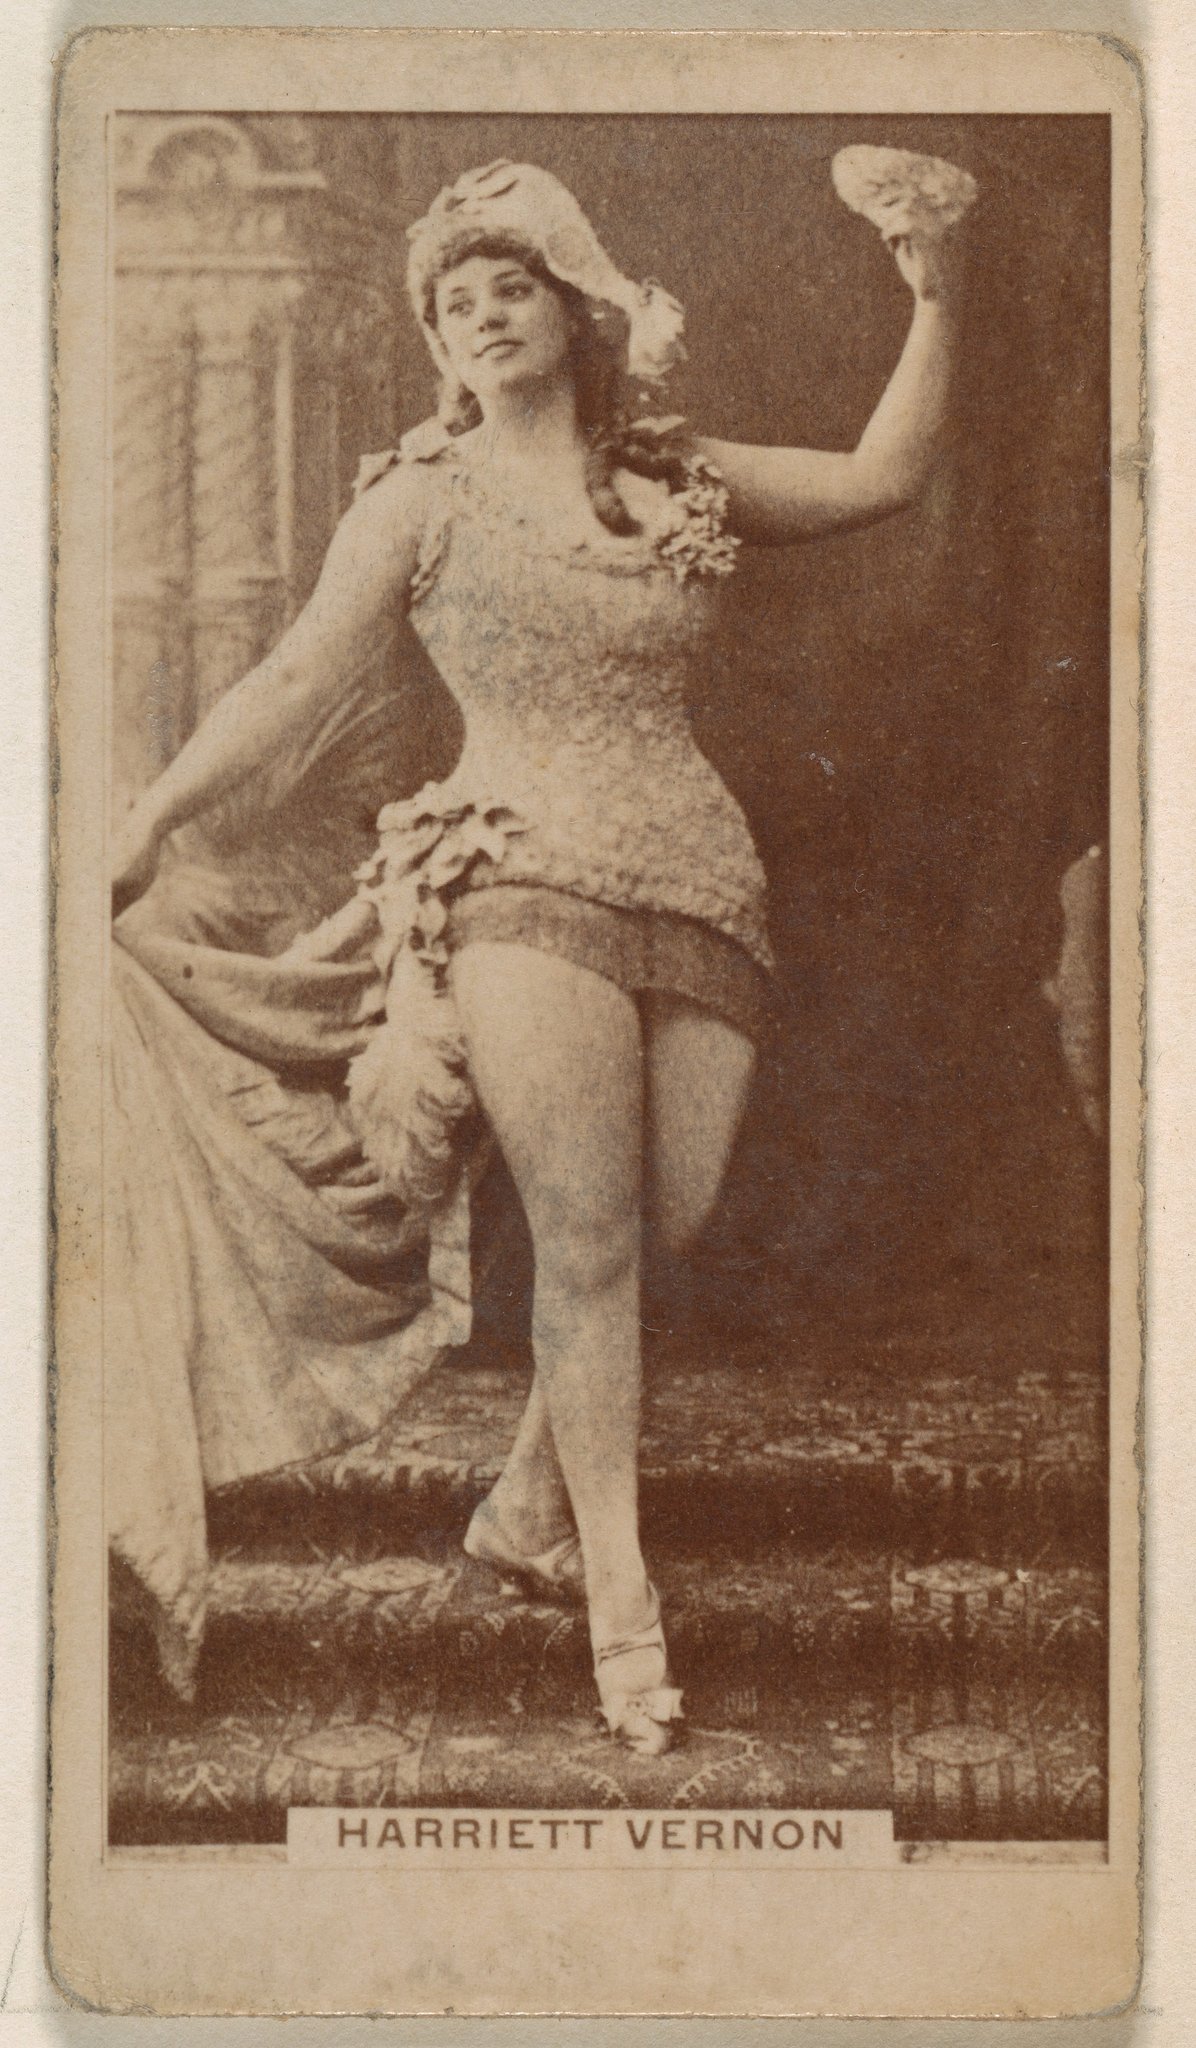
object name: photograph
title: Harriett Vernon, from the Actresses series (N245) issued by Kinney Brothers to promote Sweet Caporal Cigarettes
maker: kinney brothers tobacco company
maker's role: publisher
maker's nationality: american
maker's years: 1869-2011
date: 1890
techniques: albumen silver print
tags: portraits,women,actresses